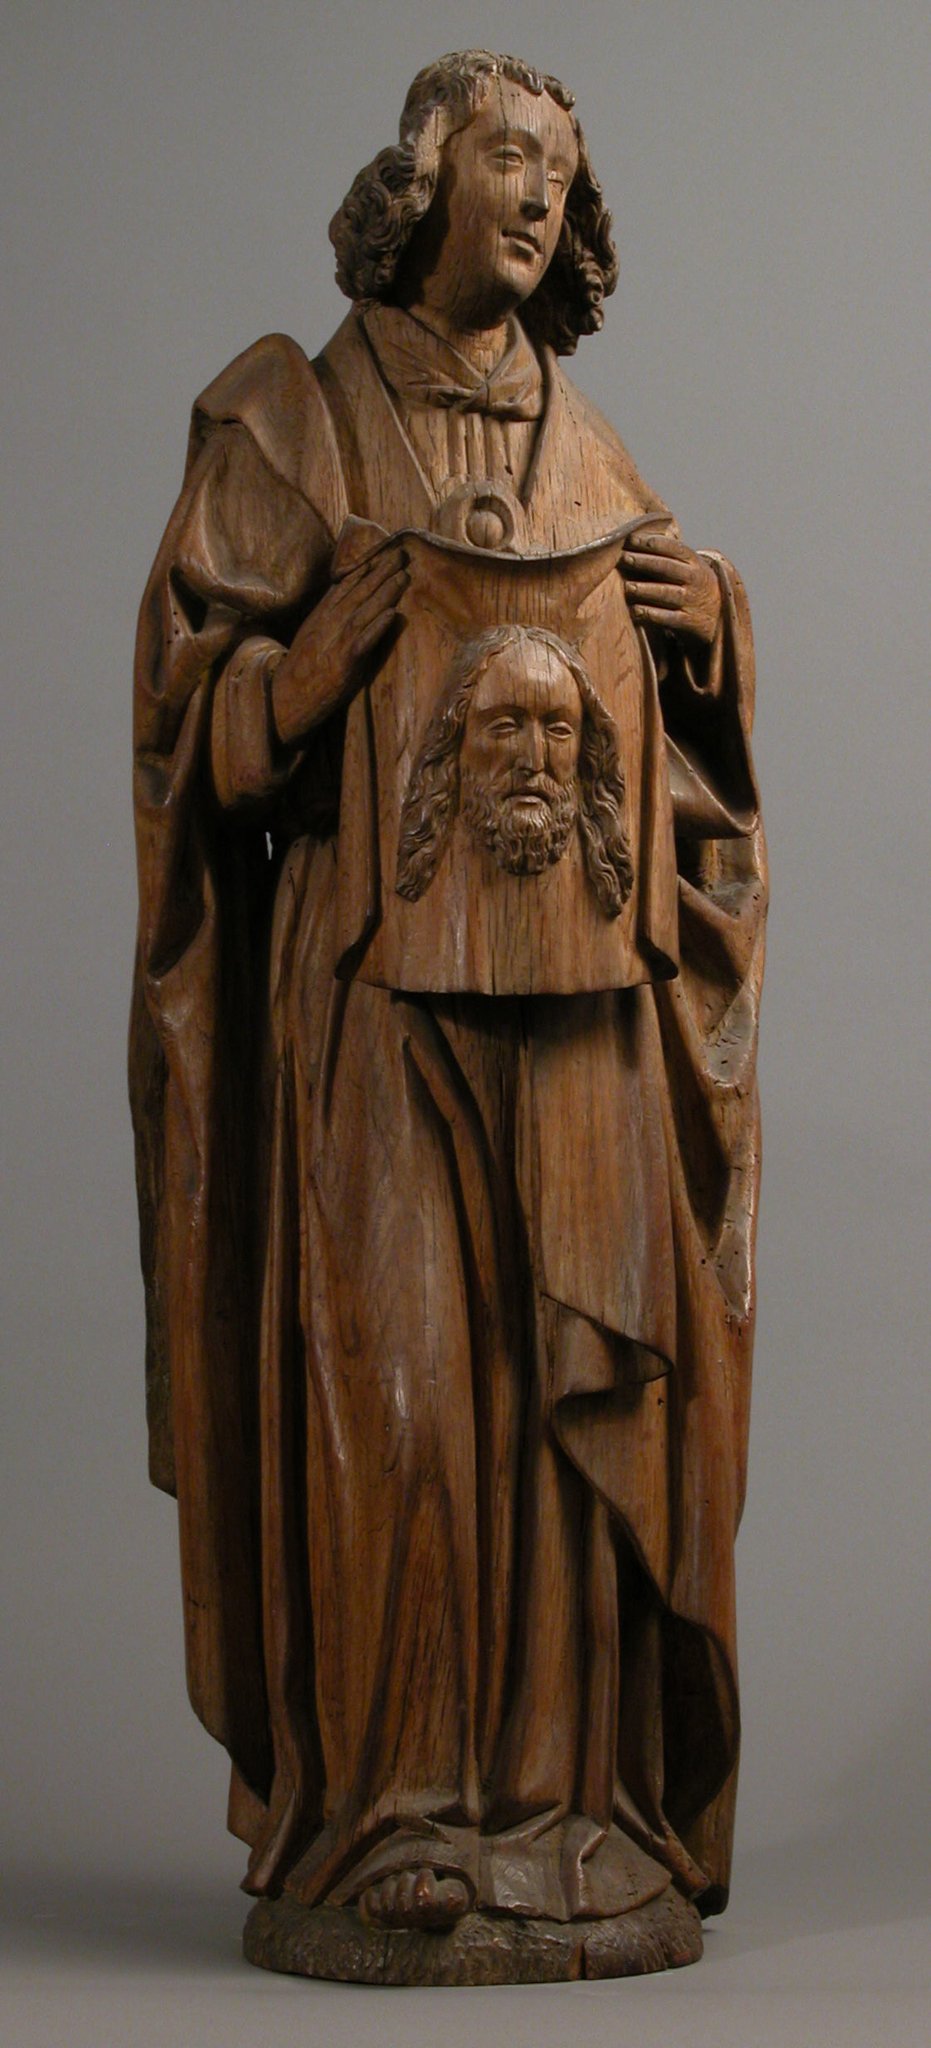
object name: statue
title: Angel with handkerchief of Saint Veronica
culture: french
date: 1500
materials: wood, paint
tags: saints